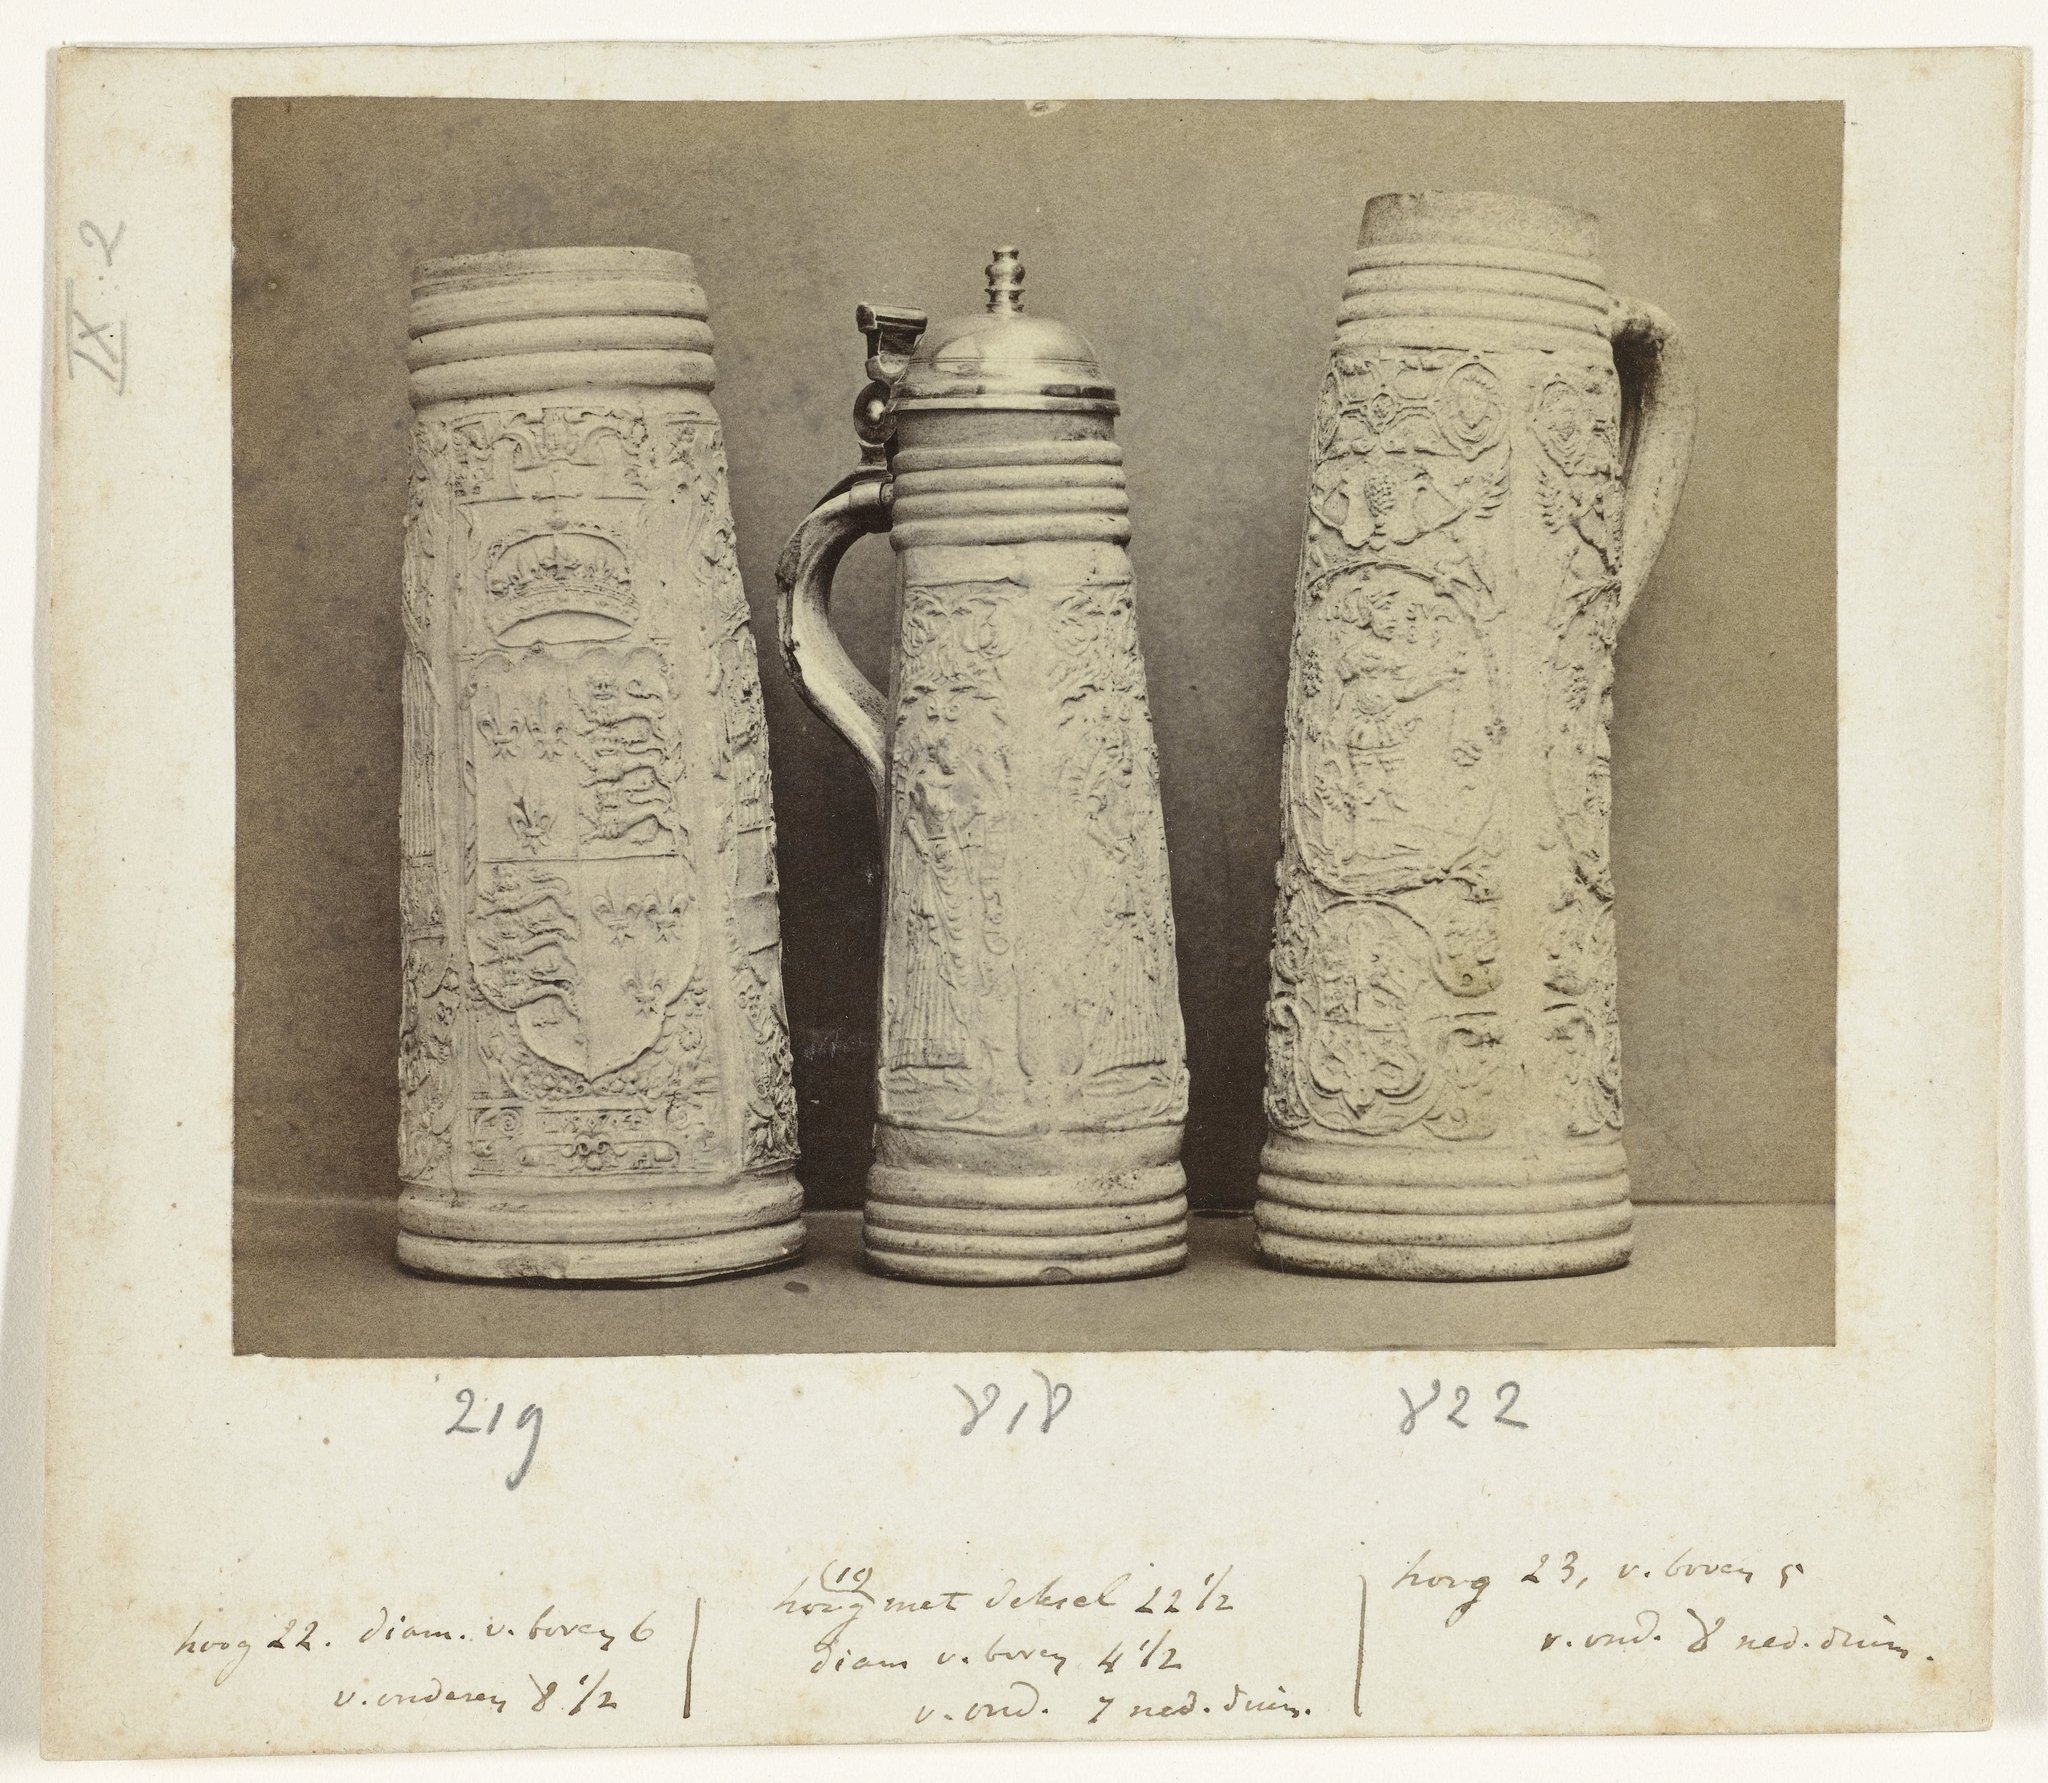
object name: photograph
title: Steengoed: drie Siegburg Schnellen (kannen) uit circa 1575-1600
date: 1863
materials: cardboard, paper, photographic support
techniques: albumen print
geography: netherlands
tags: container of stone: stone vase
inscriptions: annotation: ‘219 Hoog 22 diam. v. boven 6, v. onderen 8,5. 818. Hoog 19 met deksel 22,5 diam. v. boven 4,5 v. ond. 7 ned. duim. 822. Hoog 23, v. boven 5 v. ond. 8 ned duim.’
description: De linkerkan is in de collectie van het KOG: BK-KOG-B358-465. De kannen zijn te zien in H.C. Rogge, Album. Verzameling van afbeeldingen der merkwaardigste voorwerpen, ingezonden voor de Tentoonstelling van Oudheden